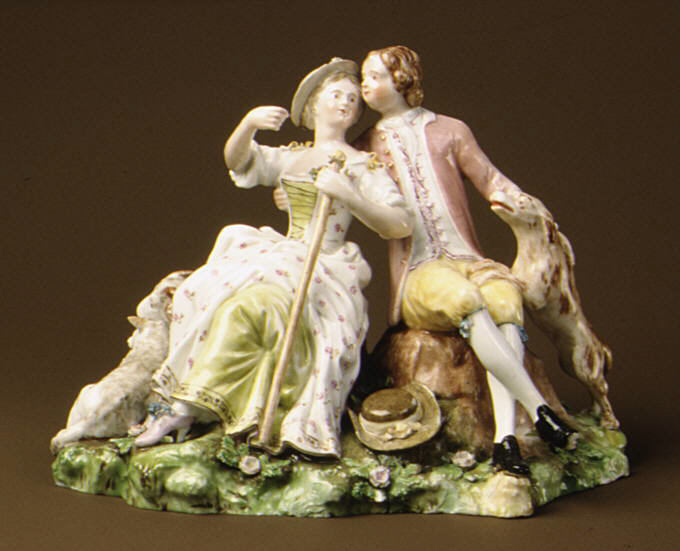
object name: group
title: Shepherd Couple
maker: royal porcelain manufactory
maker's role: factory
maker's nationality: danish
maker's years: 1775-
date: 1775-1780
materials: hard paste porcelain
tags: couples,dogs,shepherds